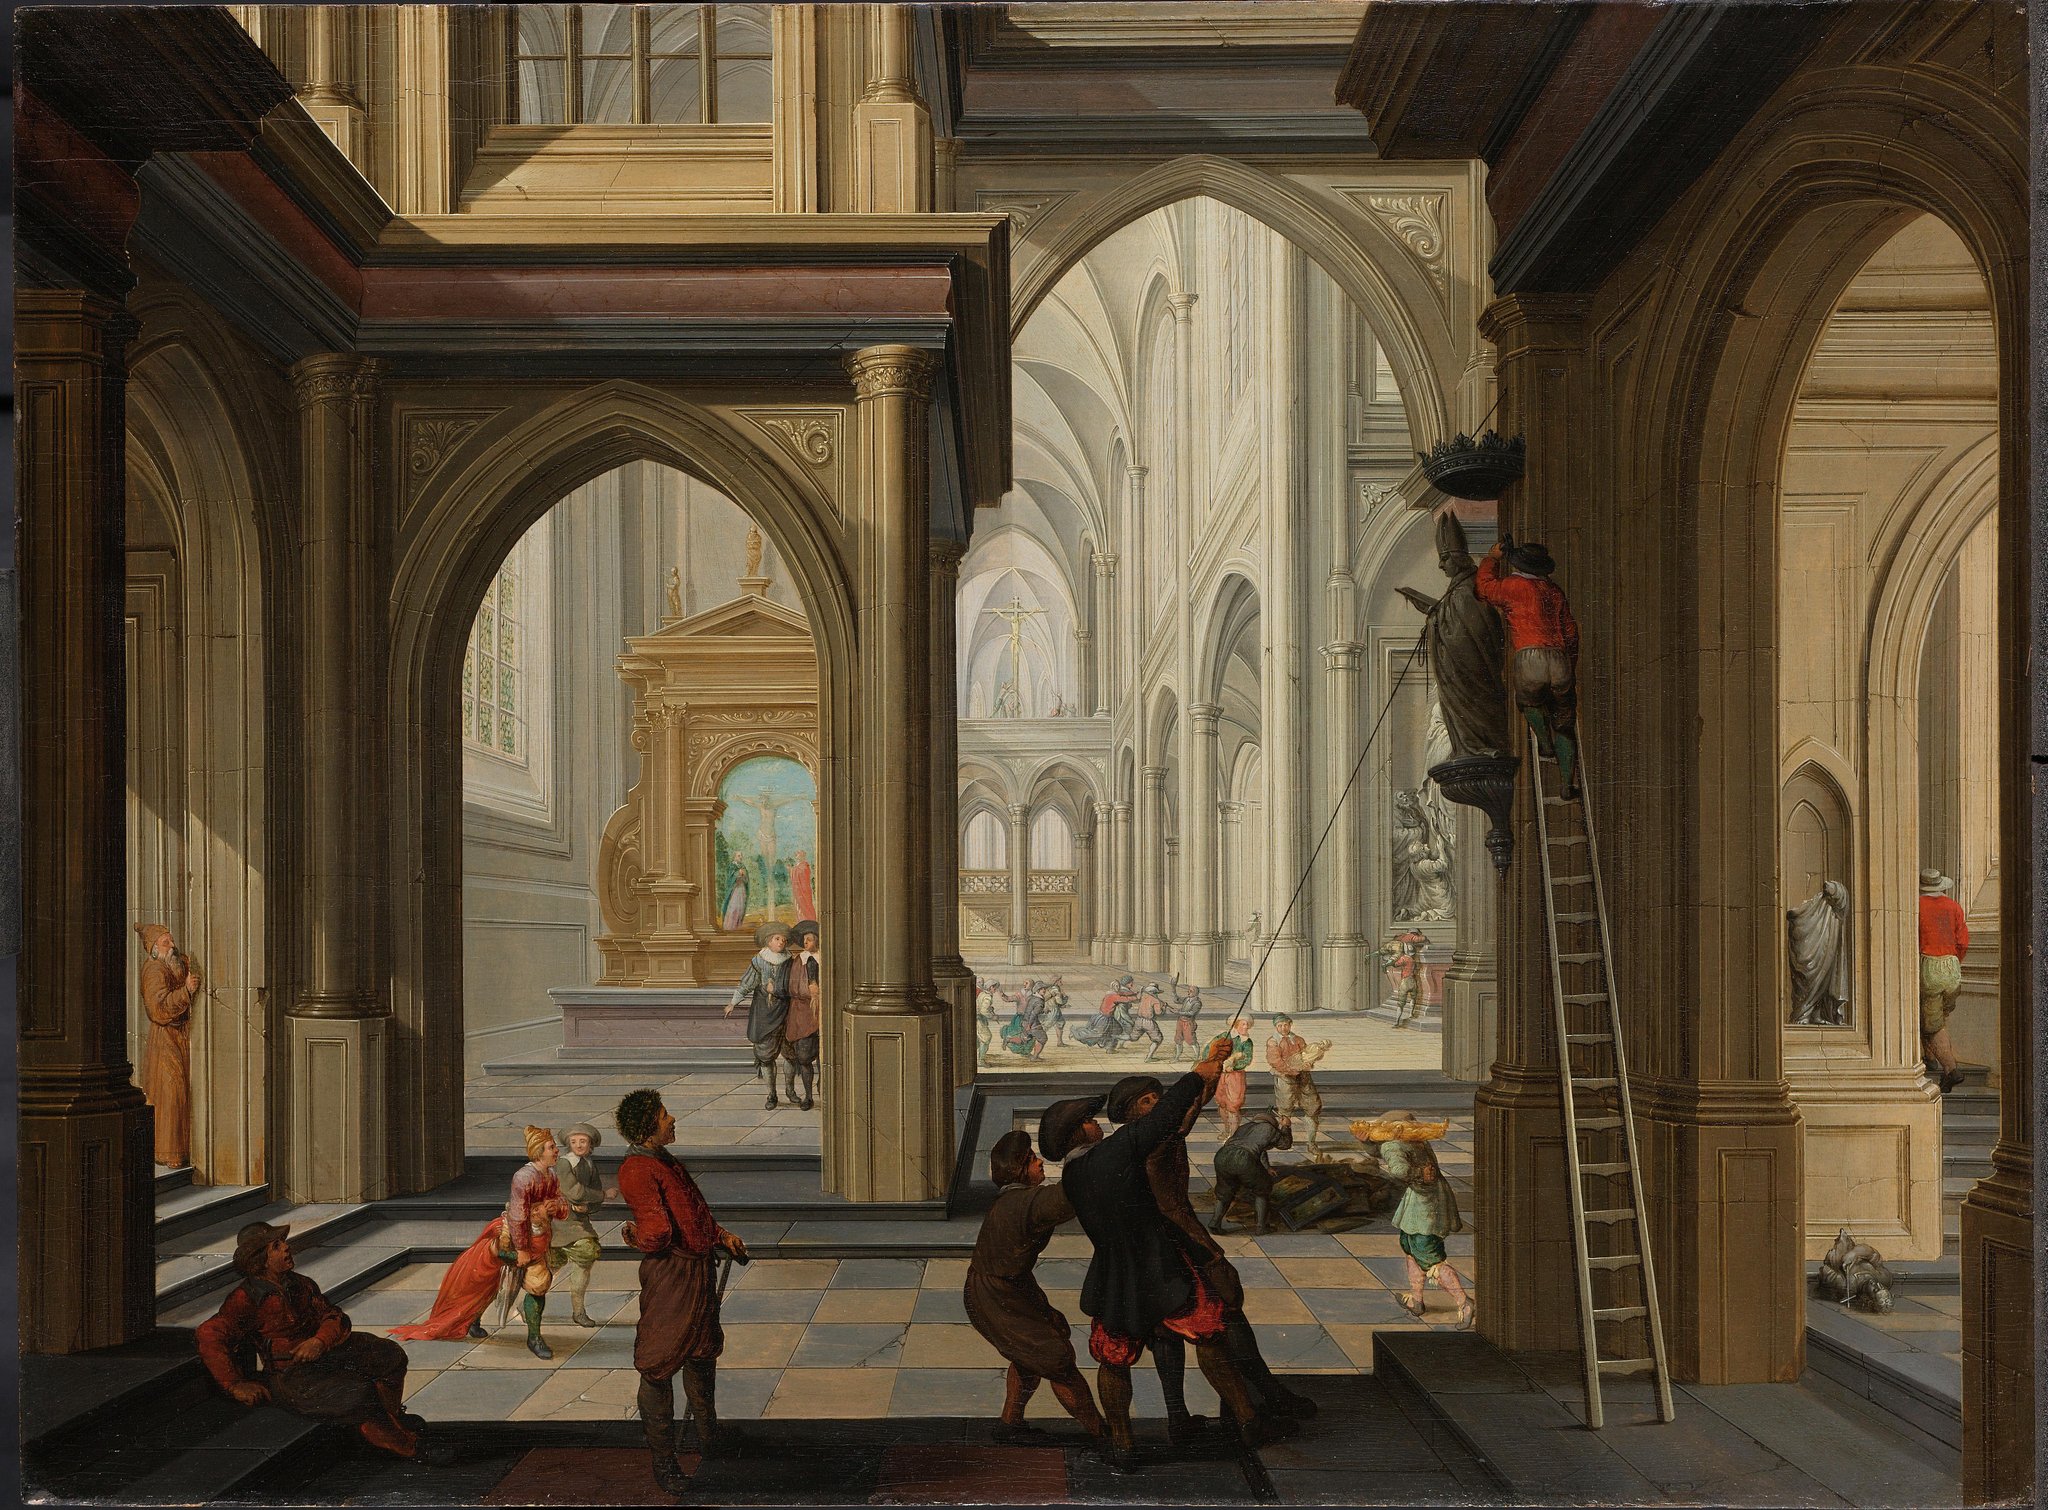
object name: painting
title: Iconoclasm in a Church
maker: dirck van delen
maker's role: painter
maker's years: 1604-1671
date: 1630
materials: wood, oil, paint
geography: netherlands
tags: interior of church, iconoclasm, netherlands, beeldenstorm (1566)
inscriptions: date: ‘1630’, signature: ‘D. V. Delen’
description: A man on a ladder has placed a noose around the neck of a statue of a saint, while below three men stand ready to topple it from its socle. At the right a statue has been brutally hacked in half. In August 1566 fanatic Protestants destroyed altarpieces, statues and sacred vessels used for the Catholic Mass in countless churches throughout the Netherlands. It was a black day in Dutch history, and one rarely depicted in art.